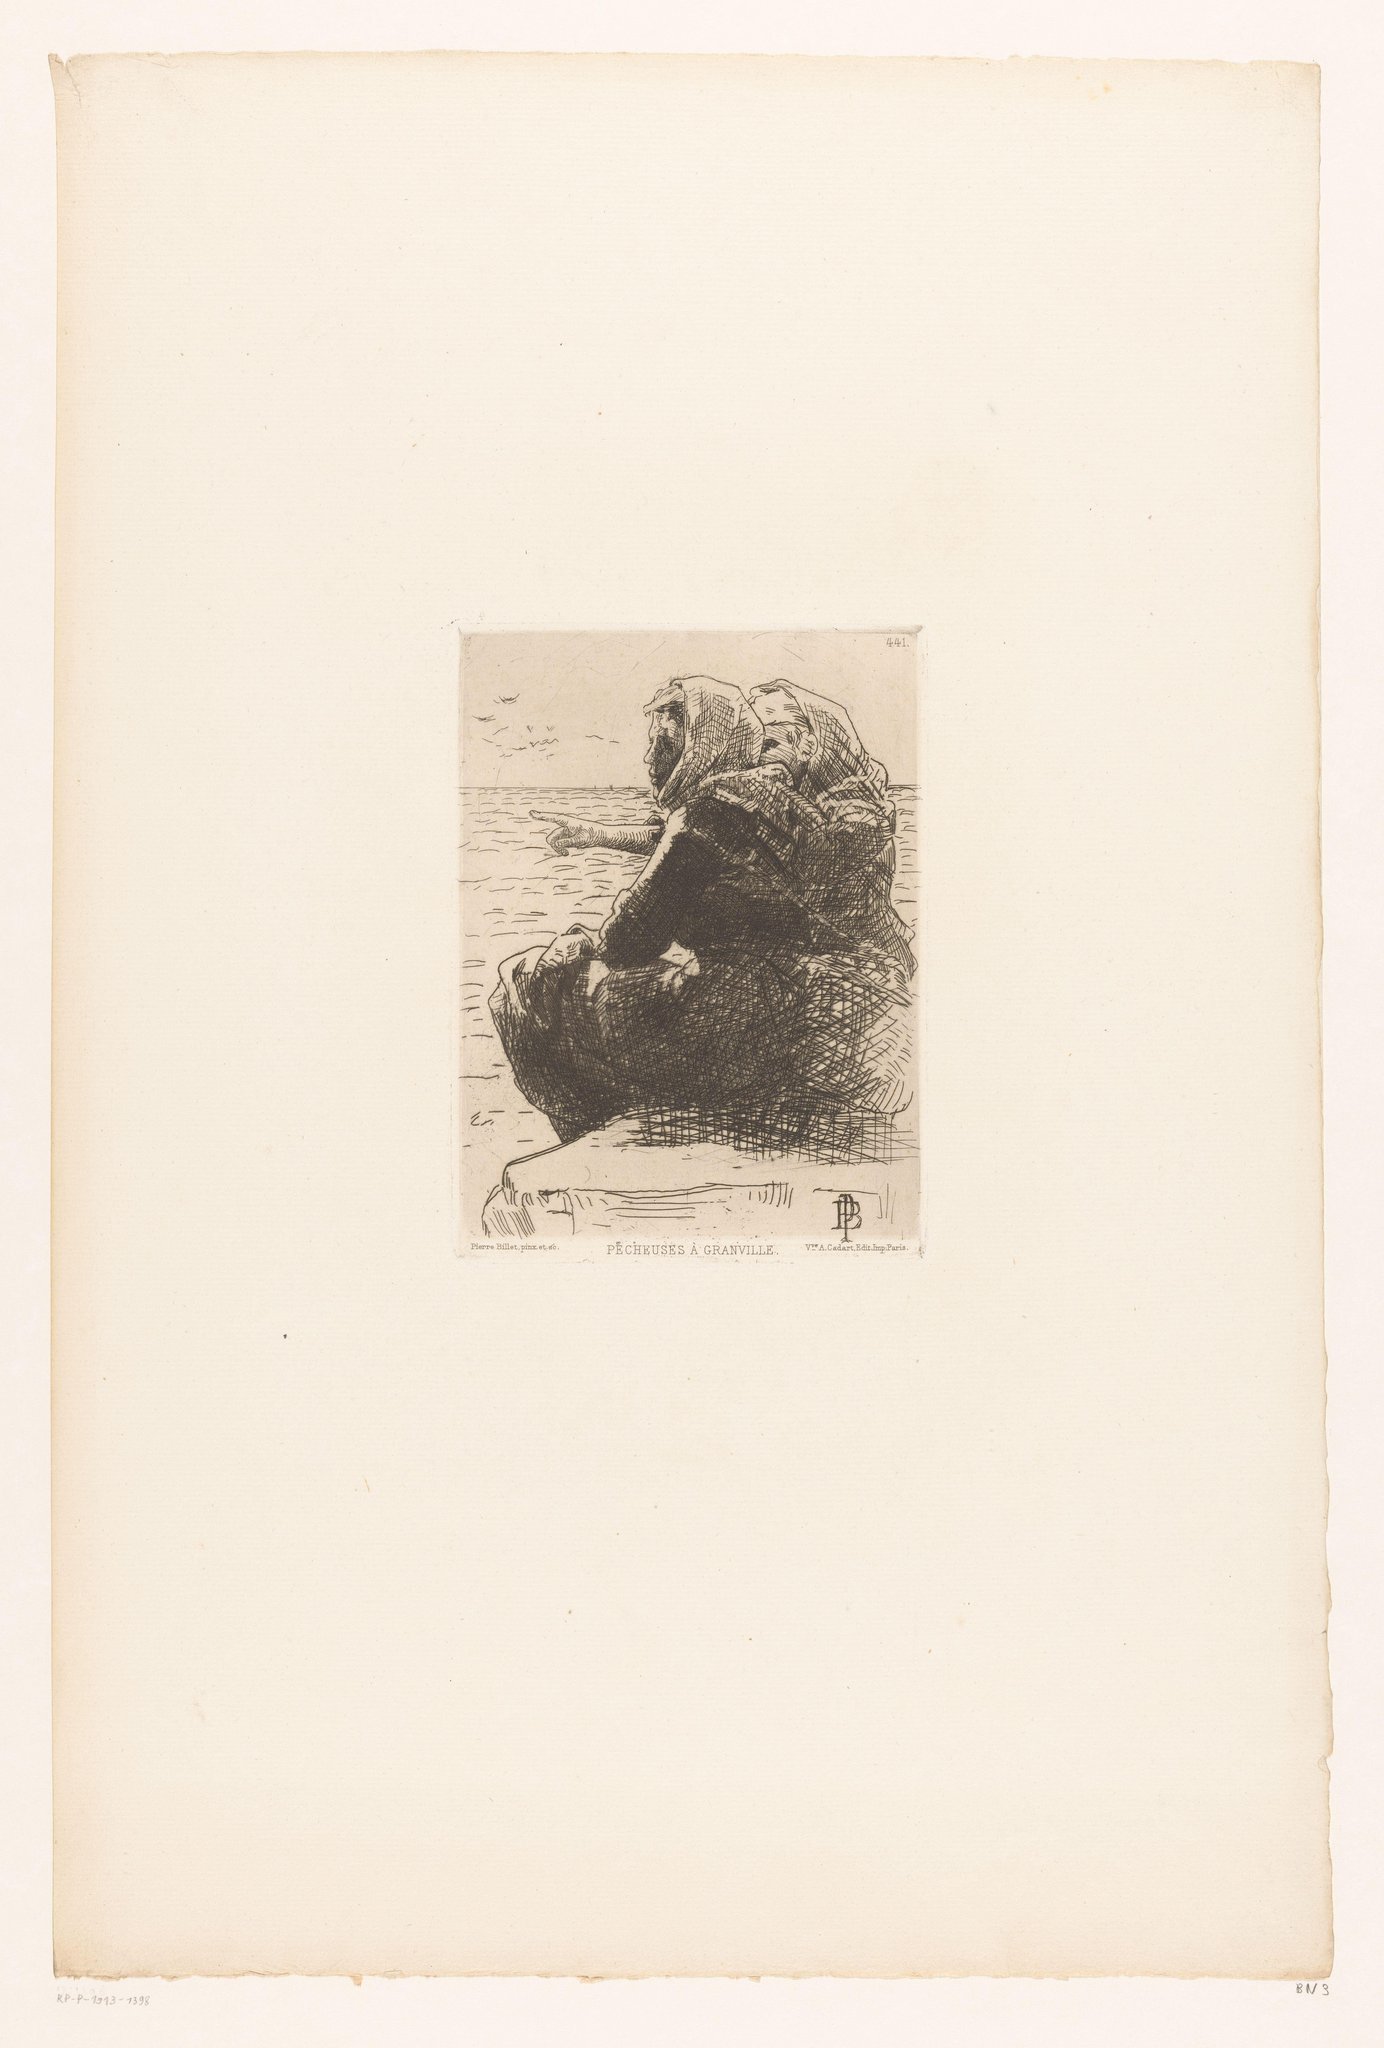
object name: print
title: Pêcheuses à Granville.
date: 1847-1913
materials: paper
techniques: drypoint, etching, intaglio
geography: paris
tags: coast, working class, labourers - aa - women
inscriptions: collector's mark: Lugt 2233